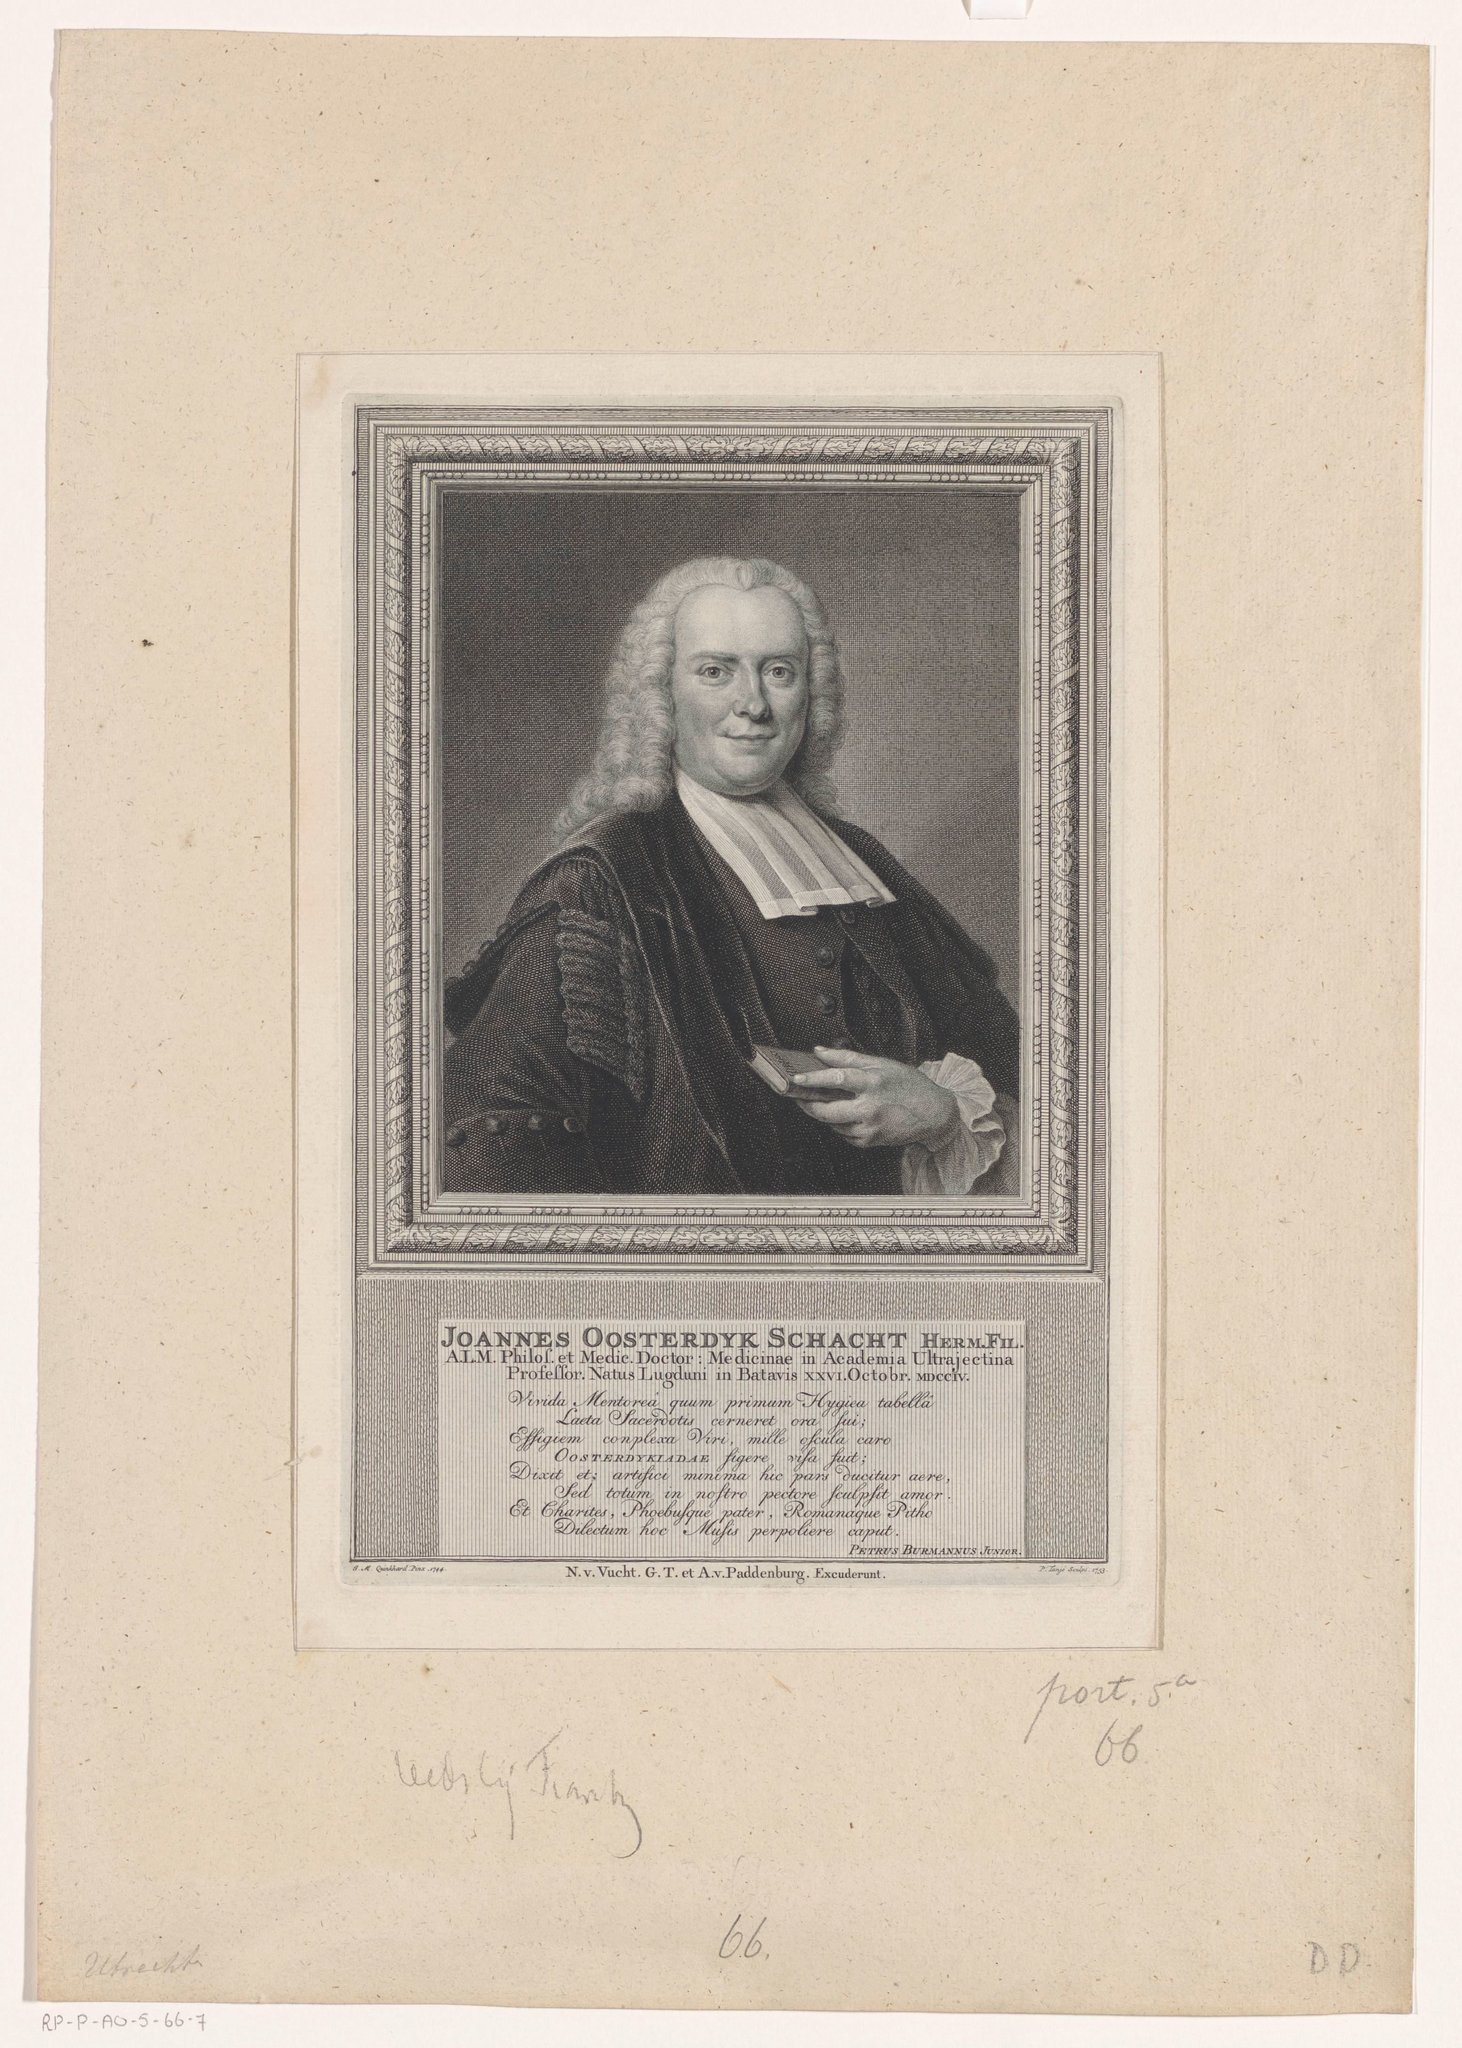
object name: print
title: Portret van Johannes Oosterdijk Schacht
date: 1753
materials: paper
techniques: engraving, etching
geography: utrecht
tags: leiden, historical persons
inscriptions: collector's mark: Lugt 195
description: Johannes Oosterdijk Schacht, filosoof en hoogleraar geneeskunde te Utrecht. Onderaan in de marge een achtregelige tekst in het Latijn.